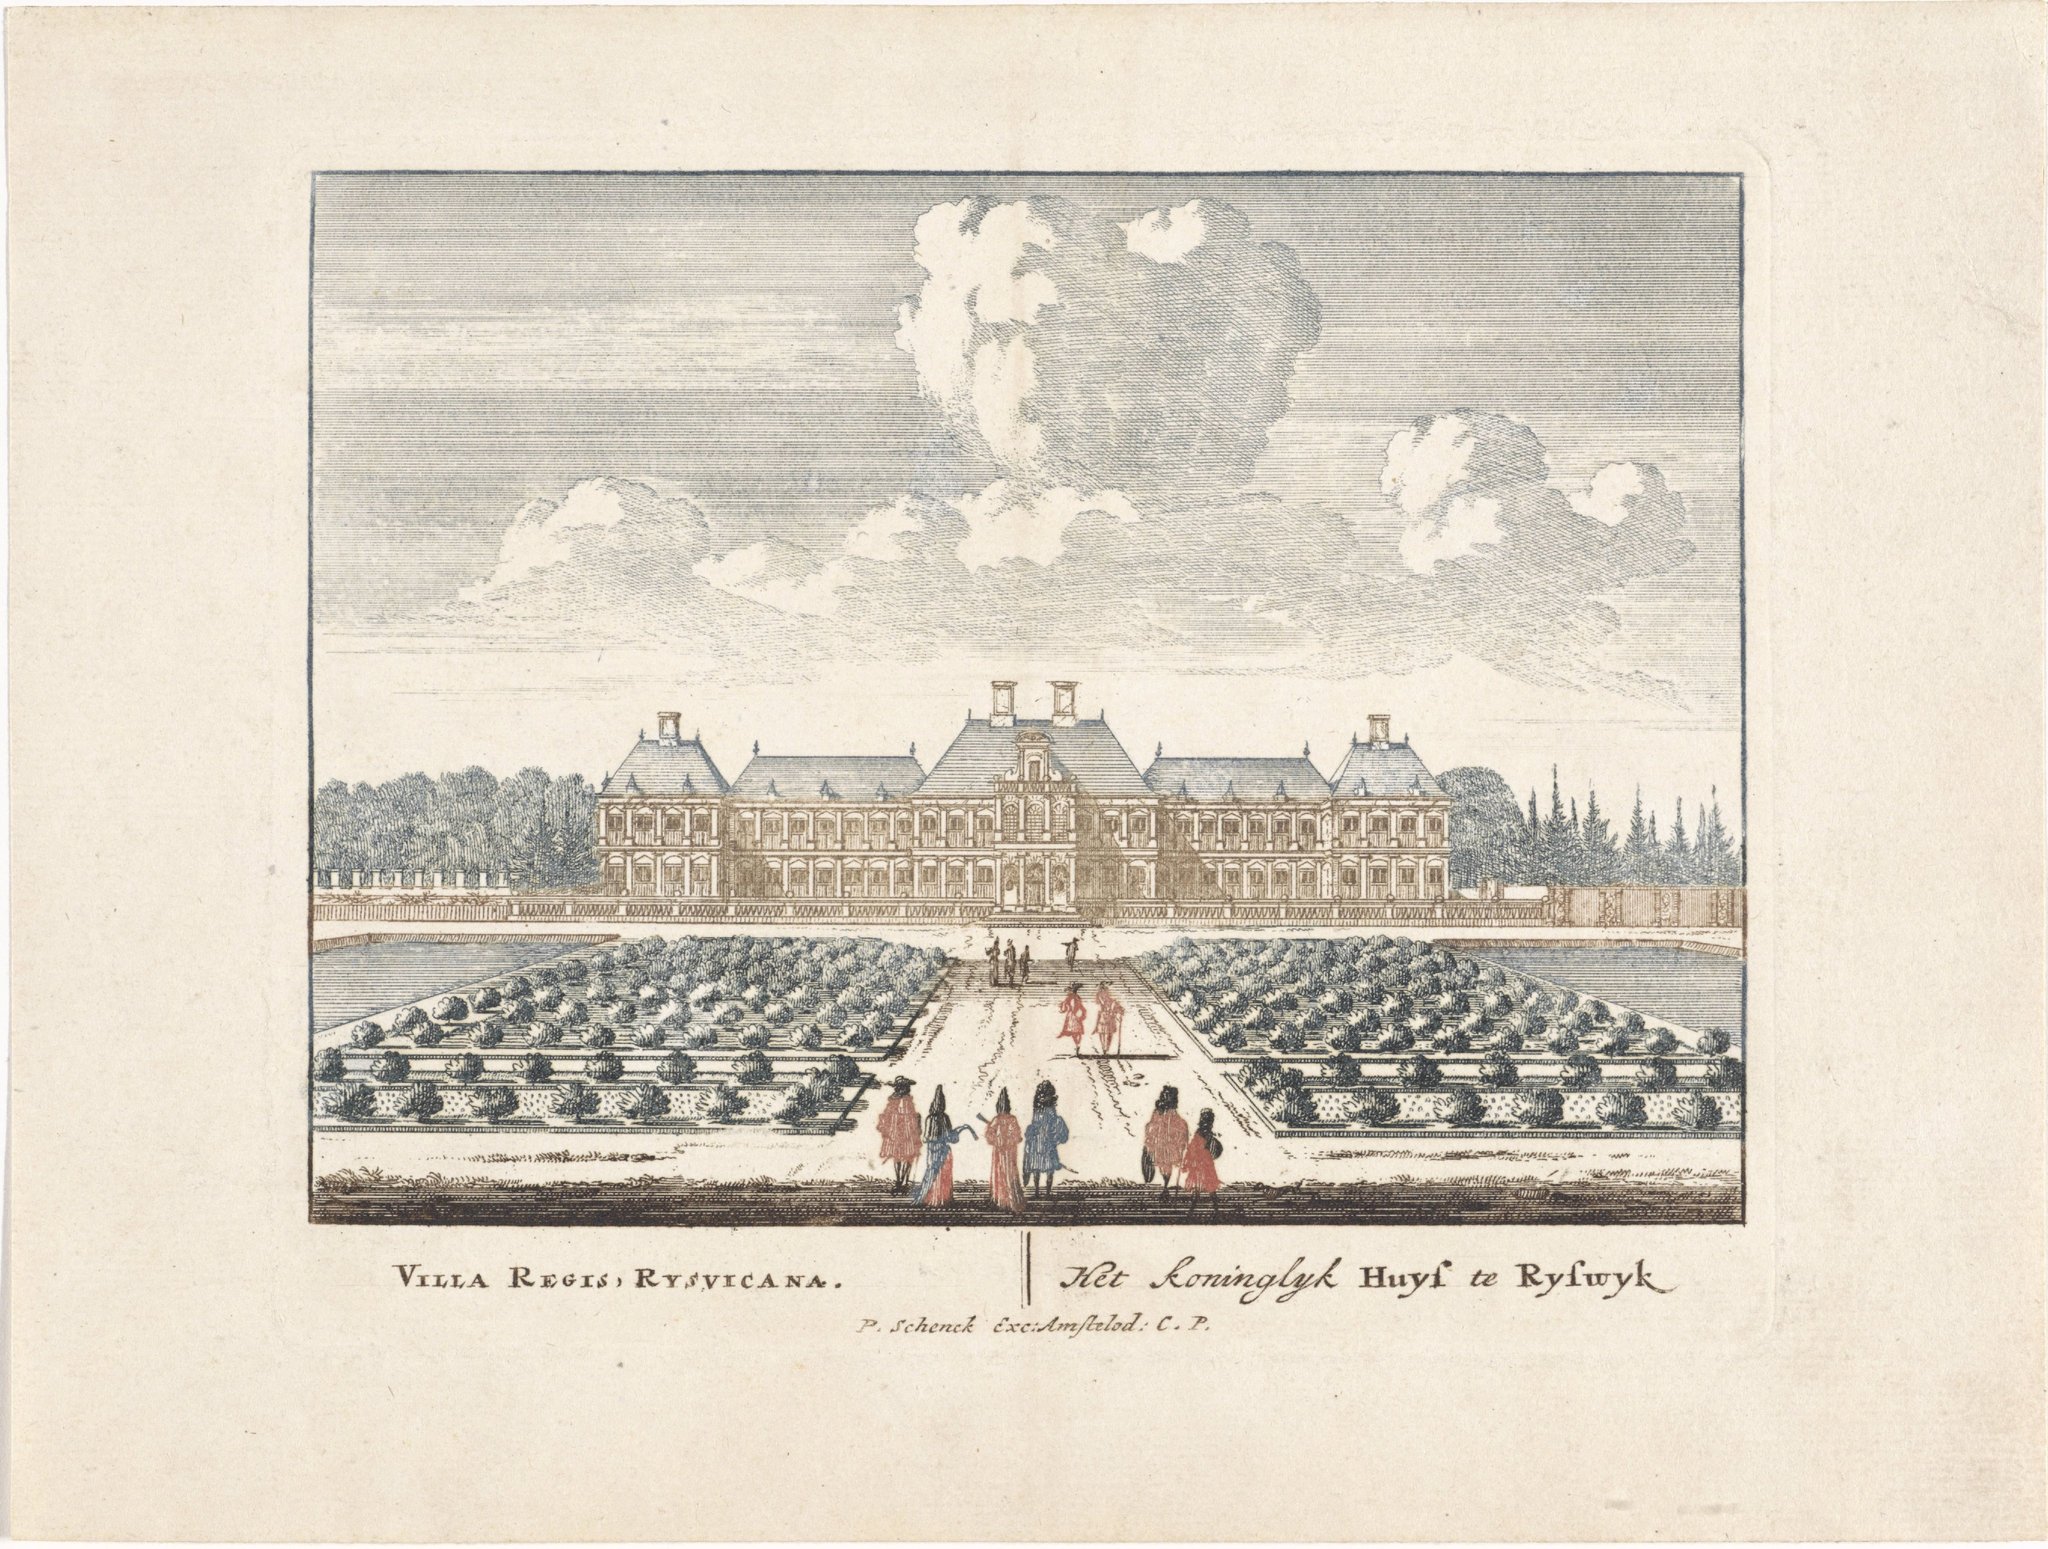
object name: print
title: Gezicht op het Huis ter Nieuburch in Rijswijk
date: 1694-1697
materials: paper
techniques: etching, lithography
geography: amsterdam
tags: palace, french or architectonic garden; formal garden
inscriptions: collector's mark: Lugt 2228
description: Zicht op het koninklijk paleis over de vijvers en tuinen, waardoor wandelaars lopen. Prent uit een serie van 71 prenten met Rijnlandschappen, gezichten op vorstelijke paleizen en stadsgezichten uit Den Haag en Amsterdam.